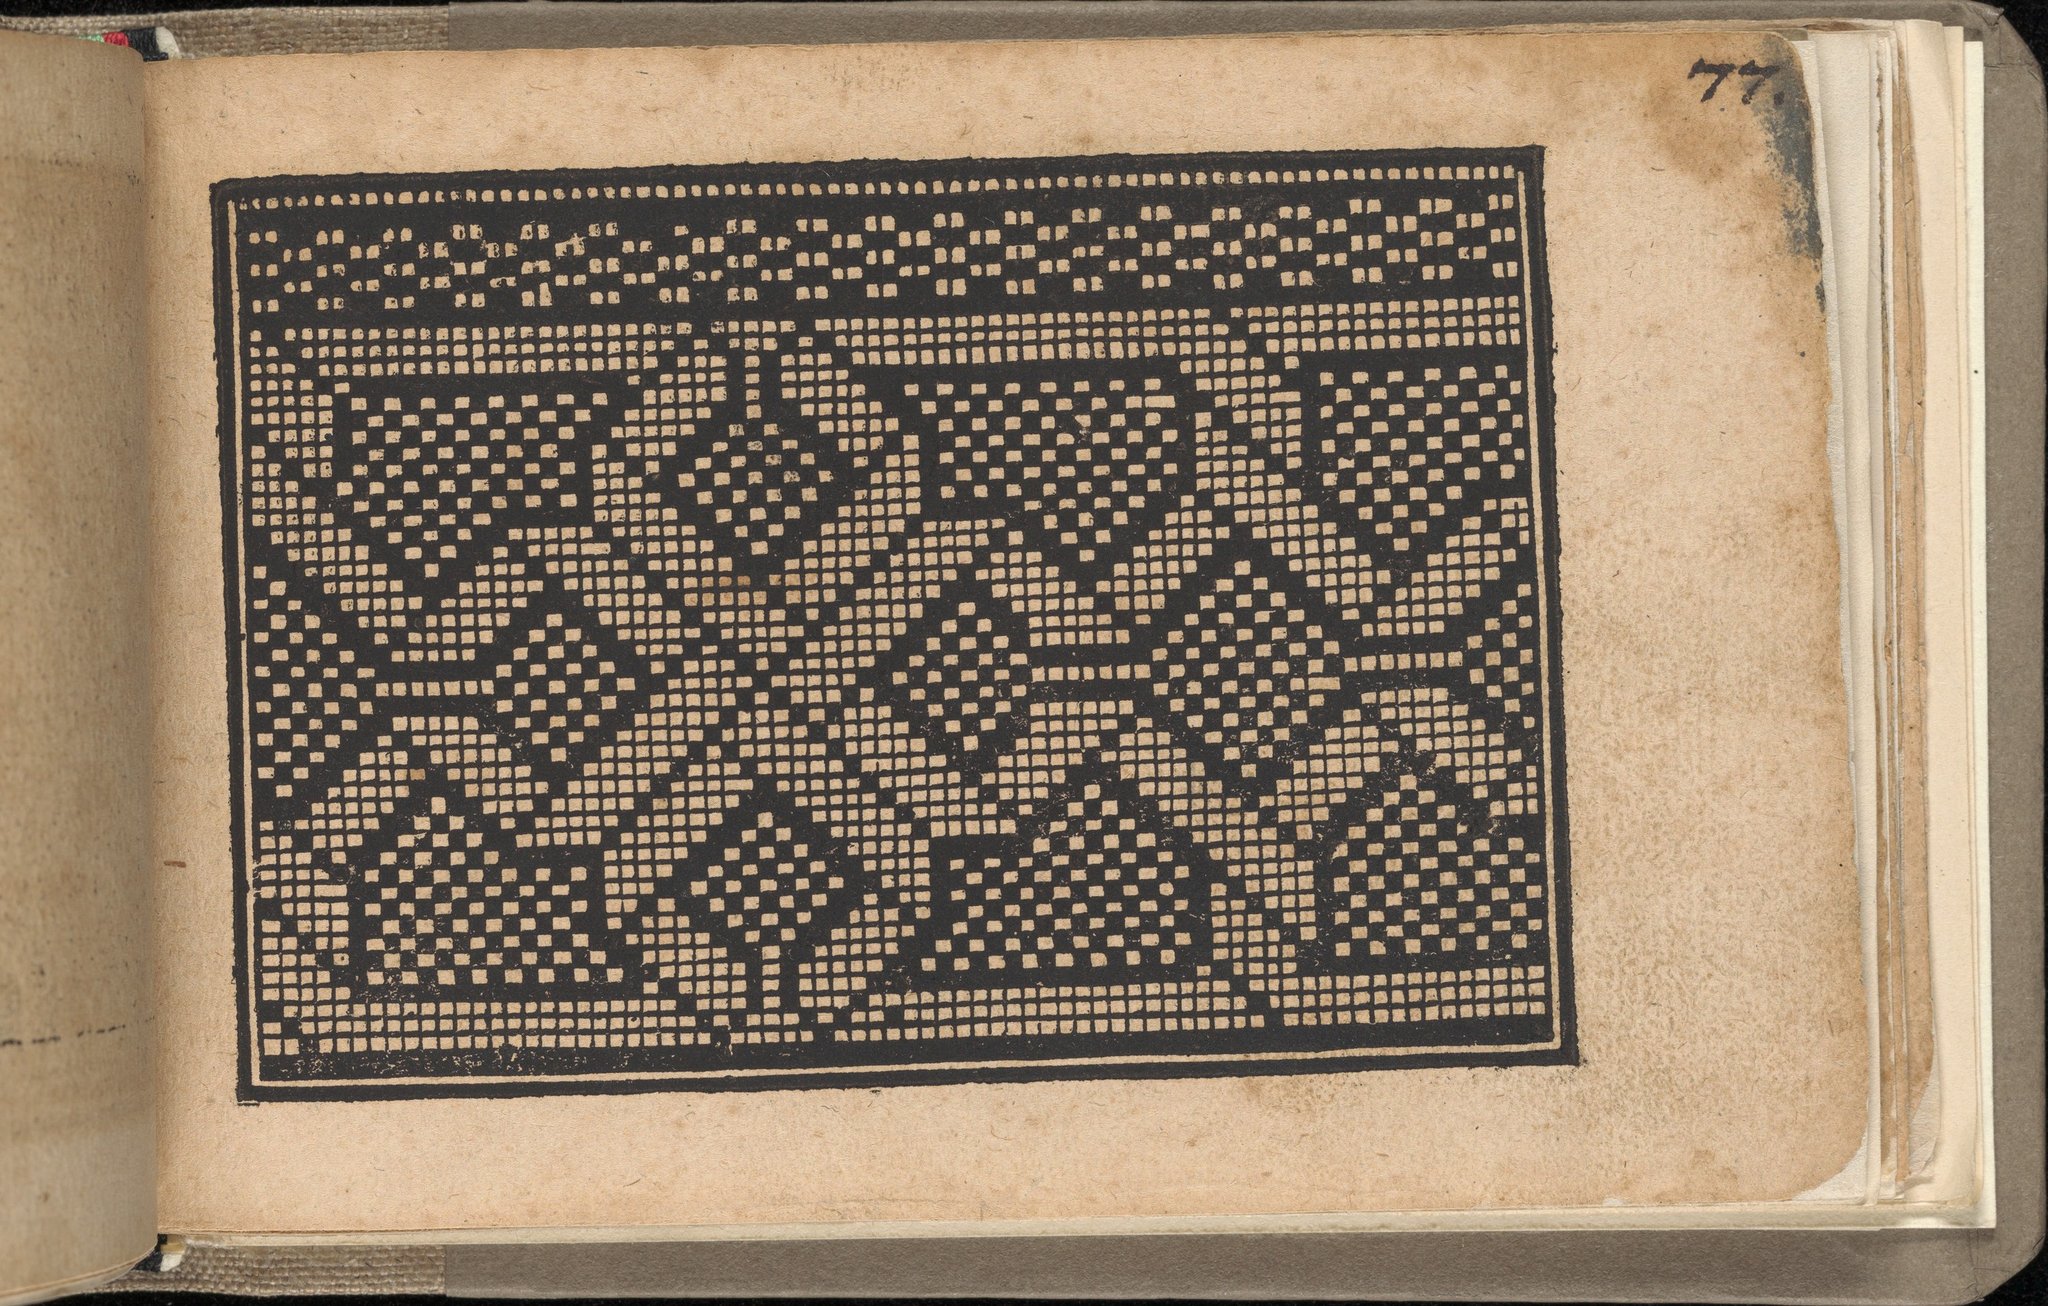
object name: book print ornament architecture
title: Schön newes Modelbuch (Page 77r)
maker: sigismundus latomus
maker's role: publisher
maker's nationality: german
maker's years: 1599-1632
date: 1608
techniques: woodcut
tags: ornament